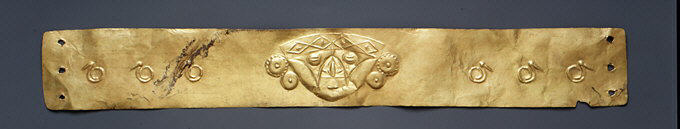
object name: diadem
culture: middle magdalena river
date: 401-1000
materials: gold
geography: colombia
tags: diadems,faces